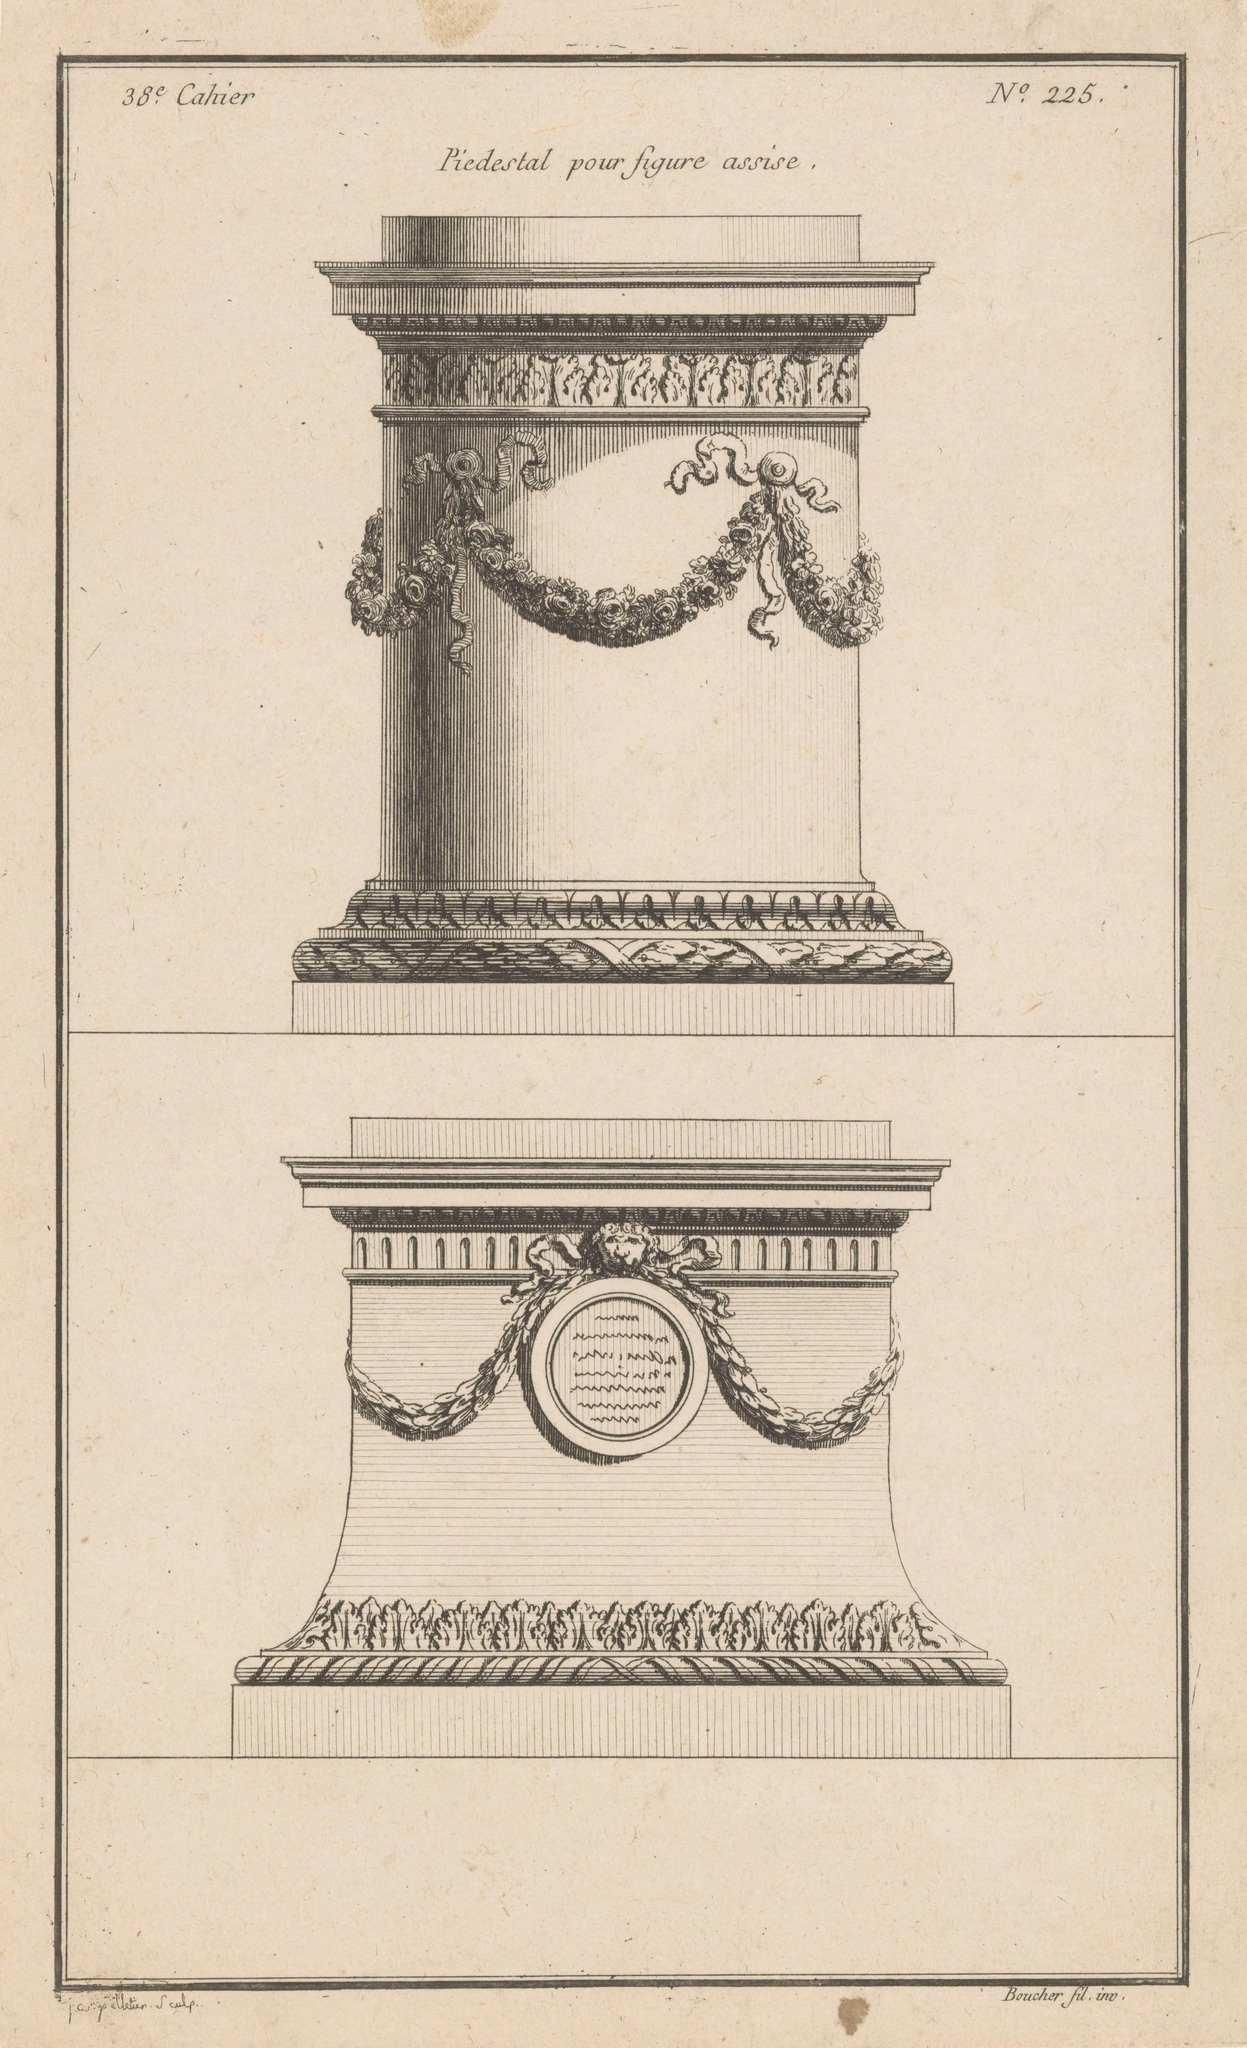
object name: print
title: Twee voetstukken met guirlandes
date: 1772-1779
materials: paper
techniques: engraving, etching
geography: paris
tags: lion's head ~ ornament, ornament ~ medallion, pedestal of a piece of sculpture (perhaps in the form of a herm), ornament ~ festoon, garland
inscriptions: collector's mark: Lugt 2760, collector's mark: Lugt 2228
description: Twee voetstukken gedecoreerd met guirlandes en bladmotieven, onder met medaillon en leeuwenkop. Prentnummer 225.